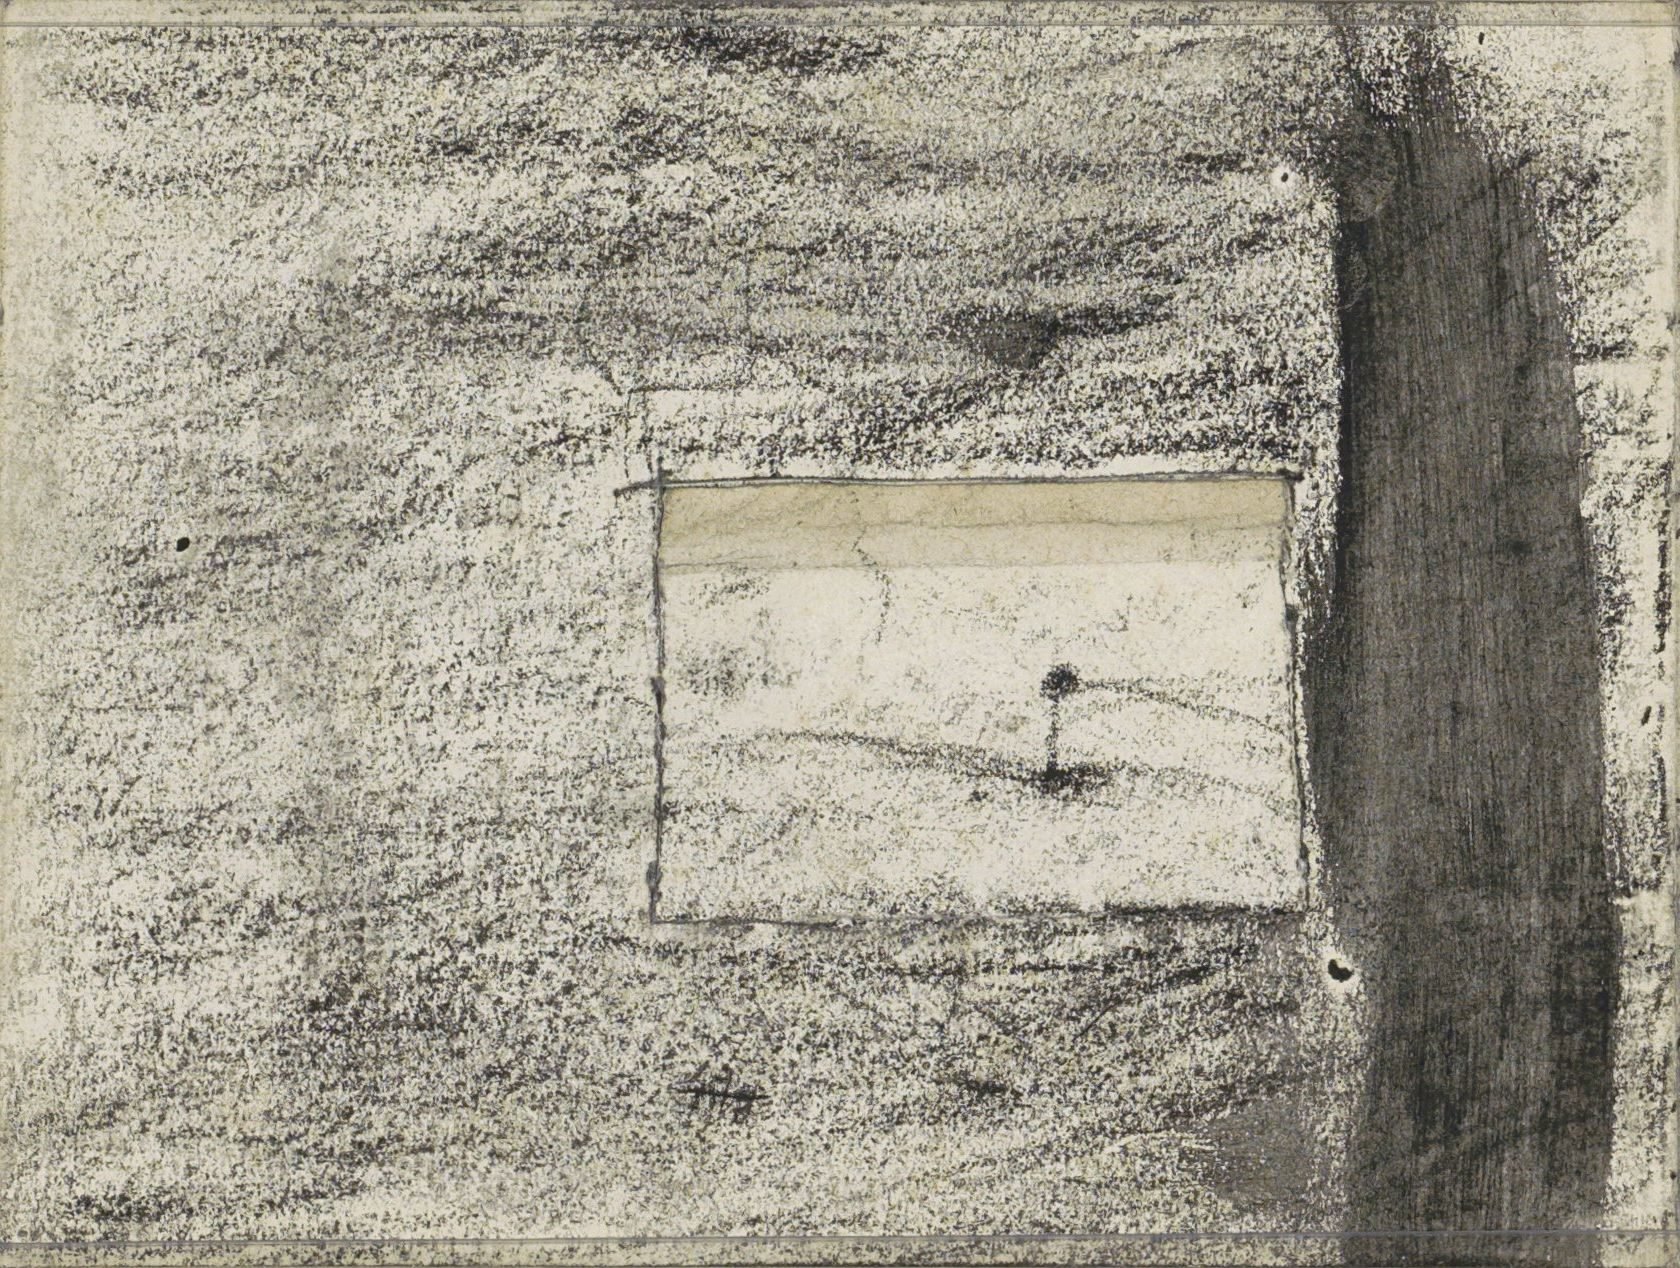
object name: sketchbook leaf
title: Studie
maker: anton mauve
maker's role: draughtsman, painter, print maker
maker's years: 1838-1888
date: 1881-1888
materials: chalk, ink, paper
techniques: brush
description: Blad 29 verso uit een schetsboek met 29 bladen.